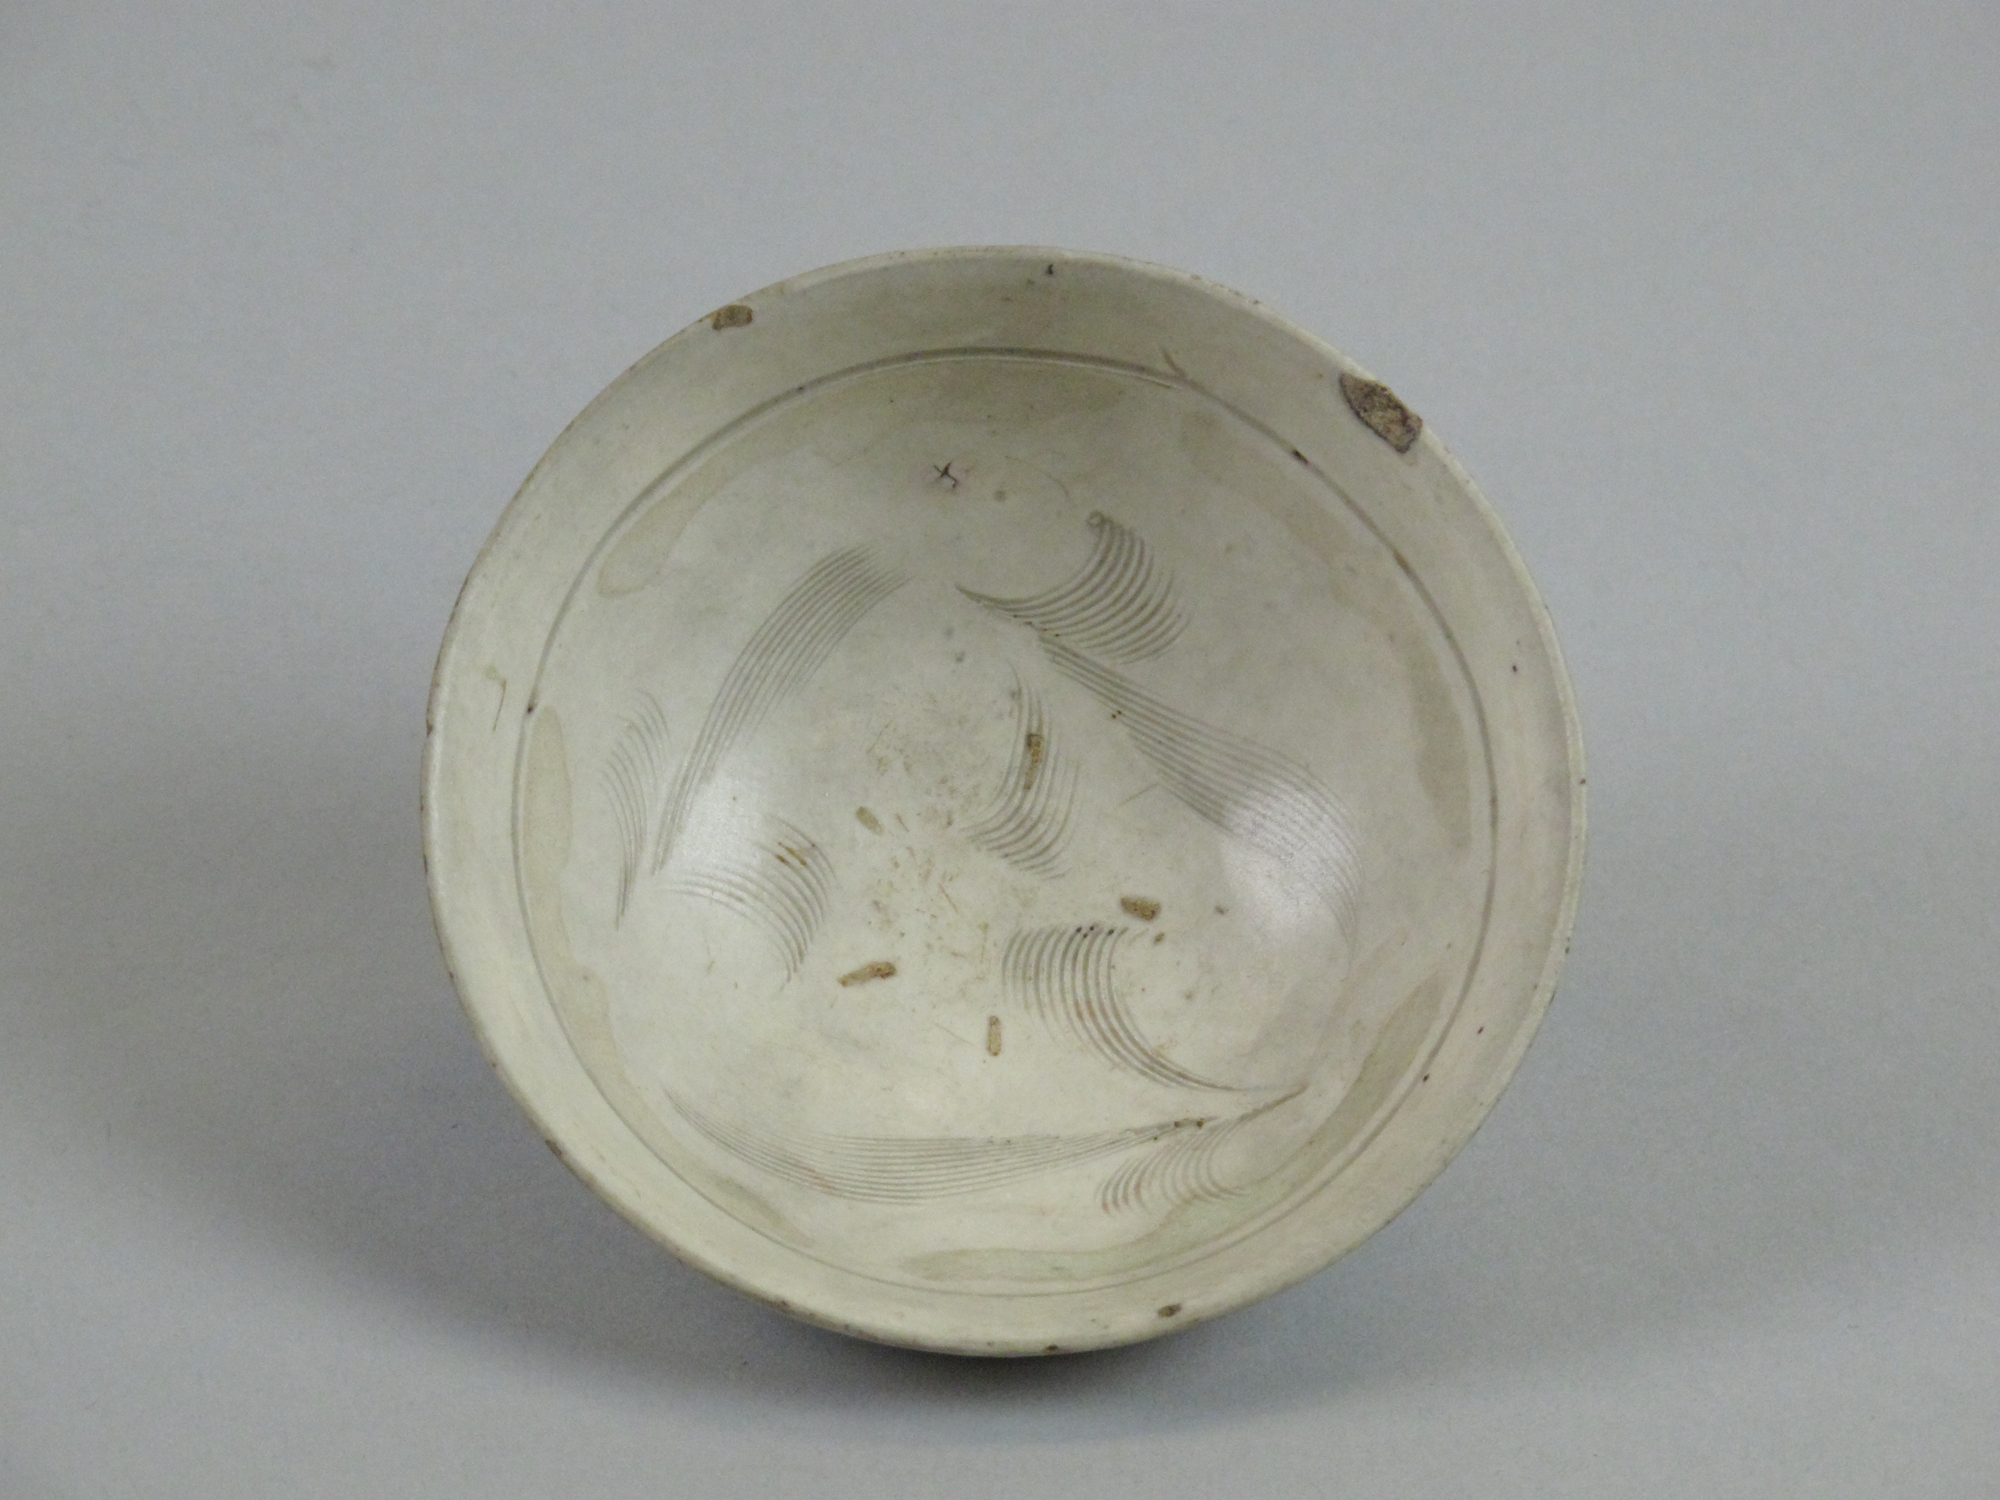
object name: bowl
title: Bowl with wave pattern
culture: chinese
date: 1201-1400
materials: enamel, stoneware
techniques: incising